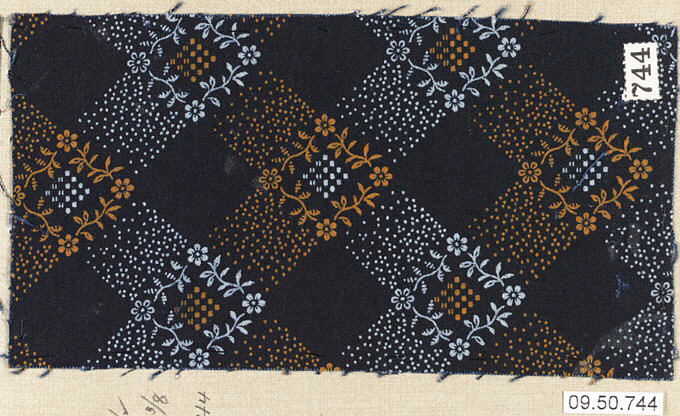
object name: piece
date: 1801-1900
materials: cotton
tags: flowers,leaves